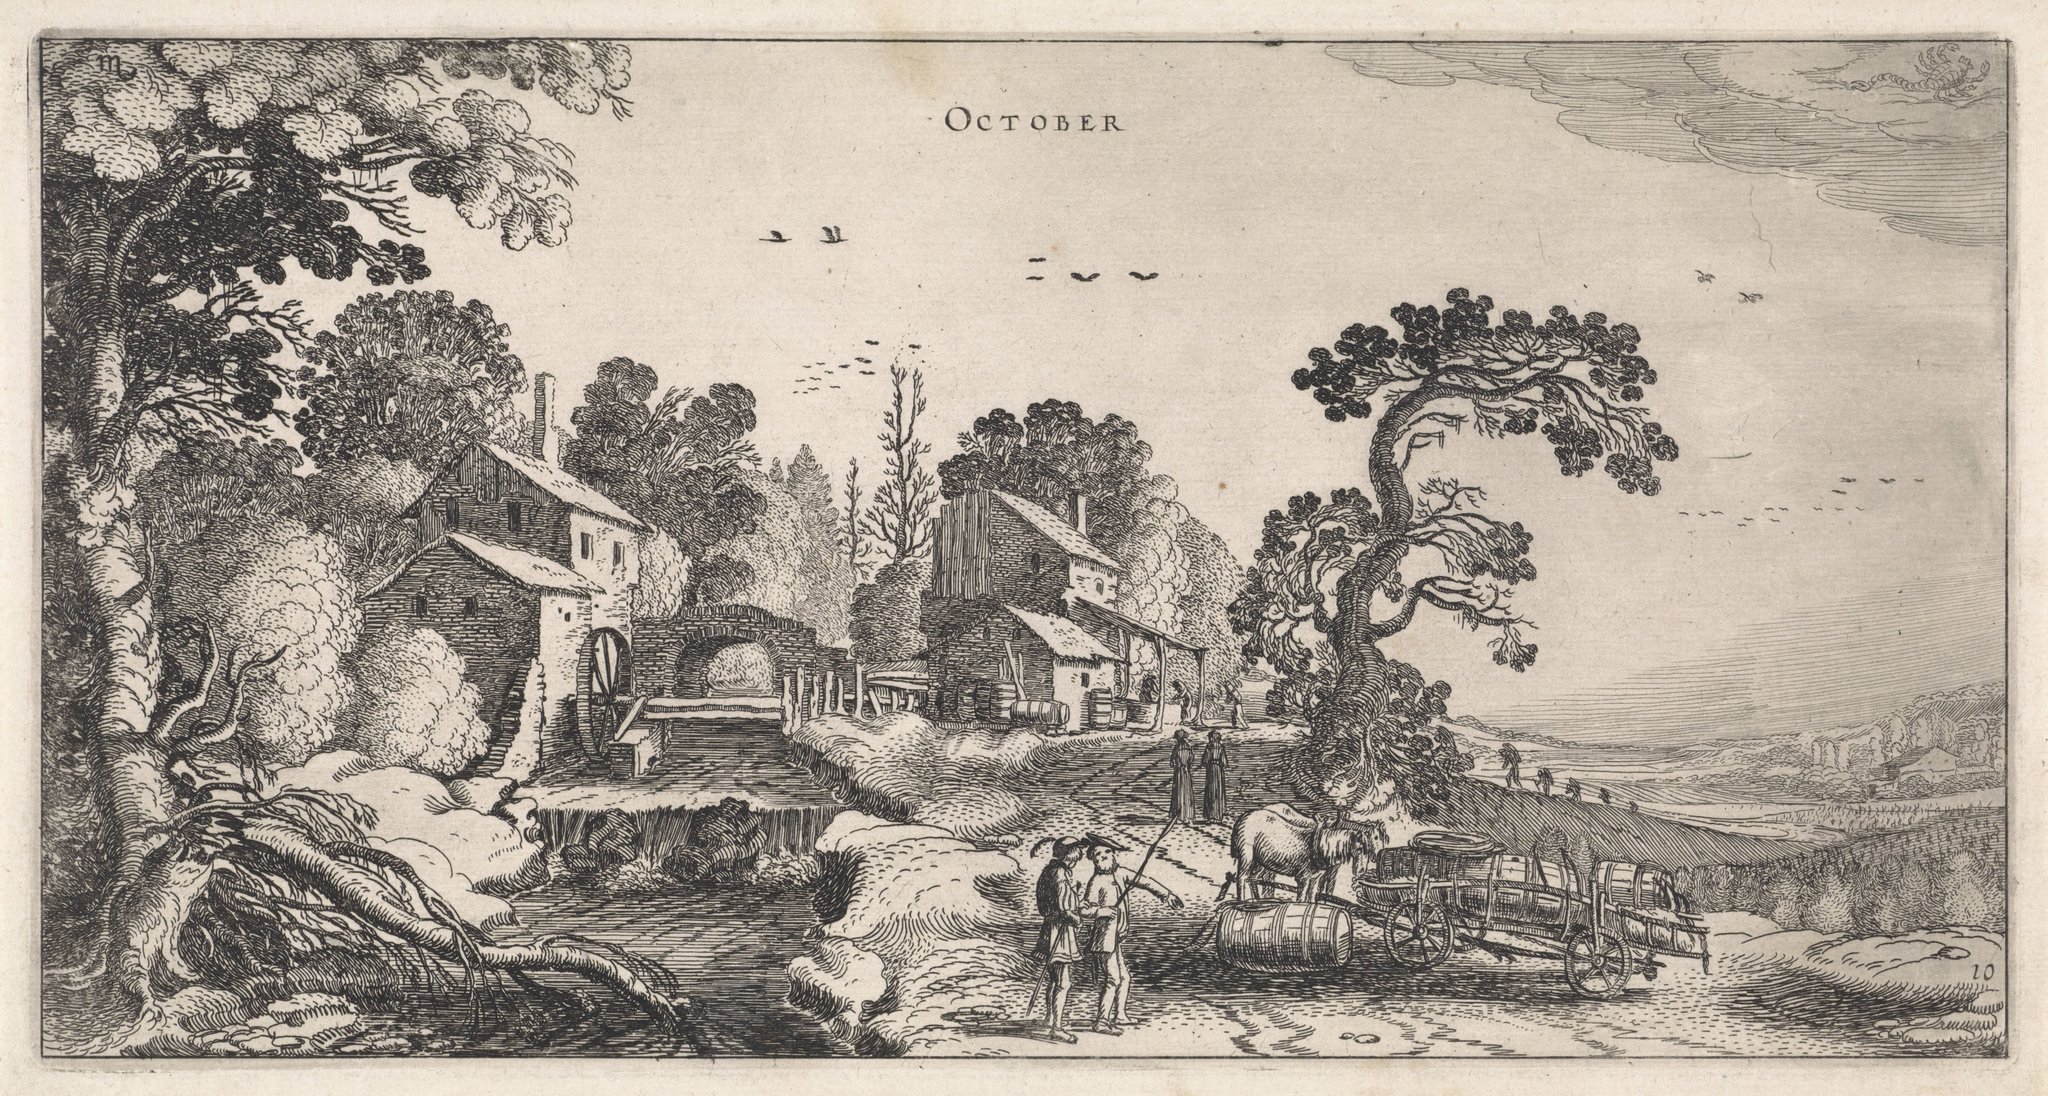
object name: print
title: Oktober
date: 1616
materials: paper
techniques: etching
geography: northern netherlands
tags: landscape symbolizing october, vineyard, scorpio (zodiacal sign of october), windmill in landscape, vintage, grape harvest, viticulture, wine-growing; vintage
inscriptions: collector's mark: Lugt 964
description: Een landschap met een watermolen en links boeren met vaten, voorstellende de maand oktober. Rechts een wijngaard op een heuvel. Links- en rechtsboven de bij deze maand behorende symbolen van het sterrenbeeld schorpioen. Tiende prent uit een serie van twaalf.